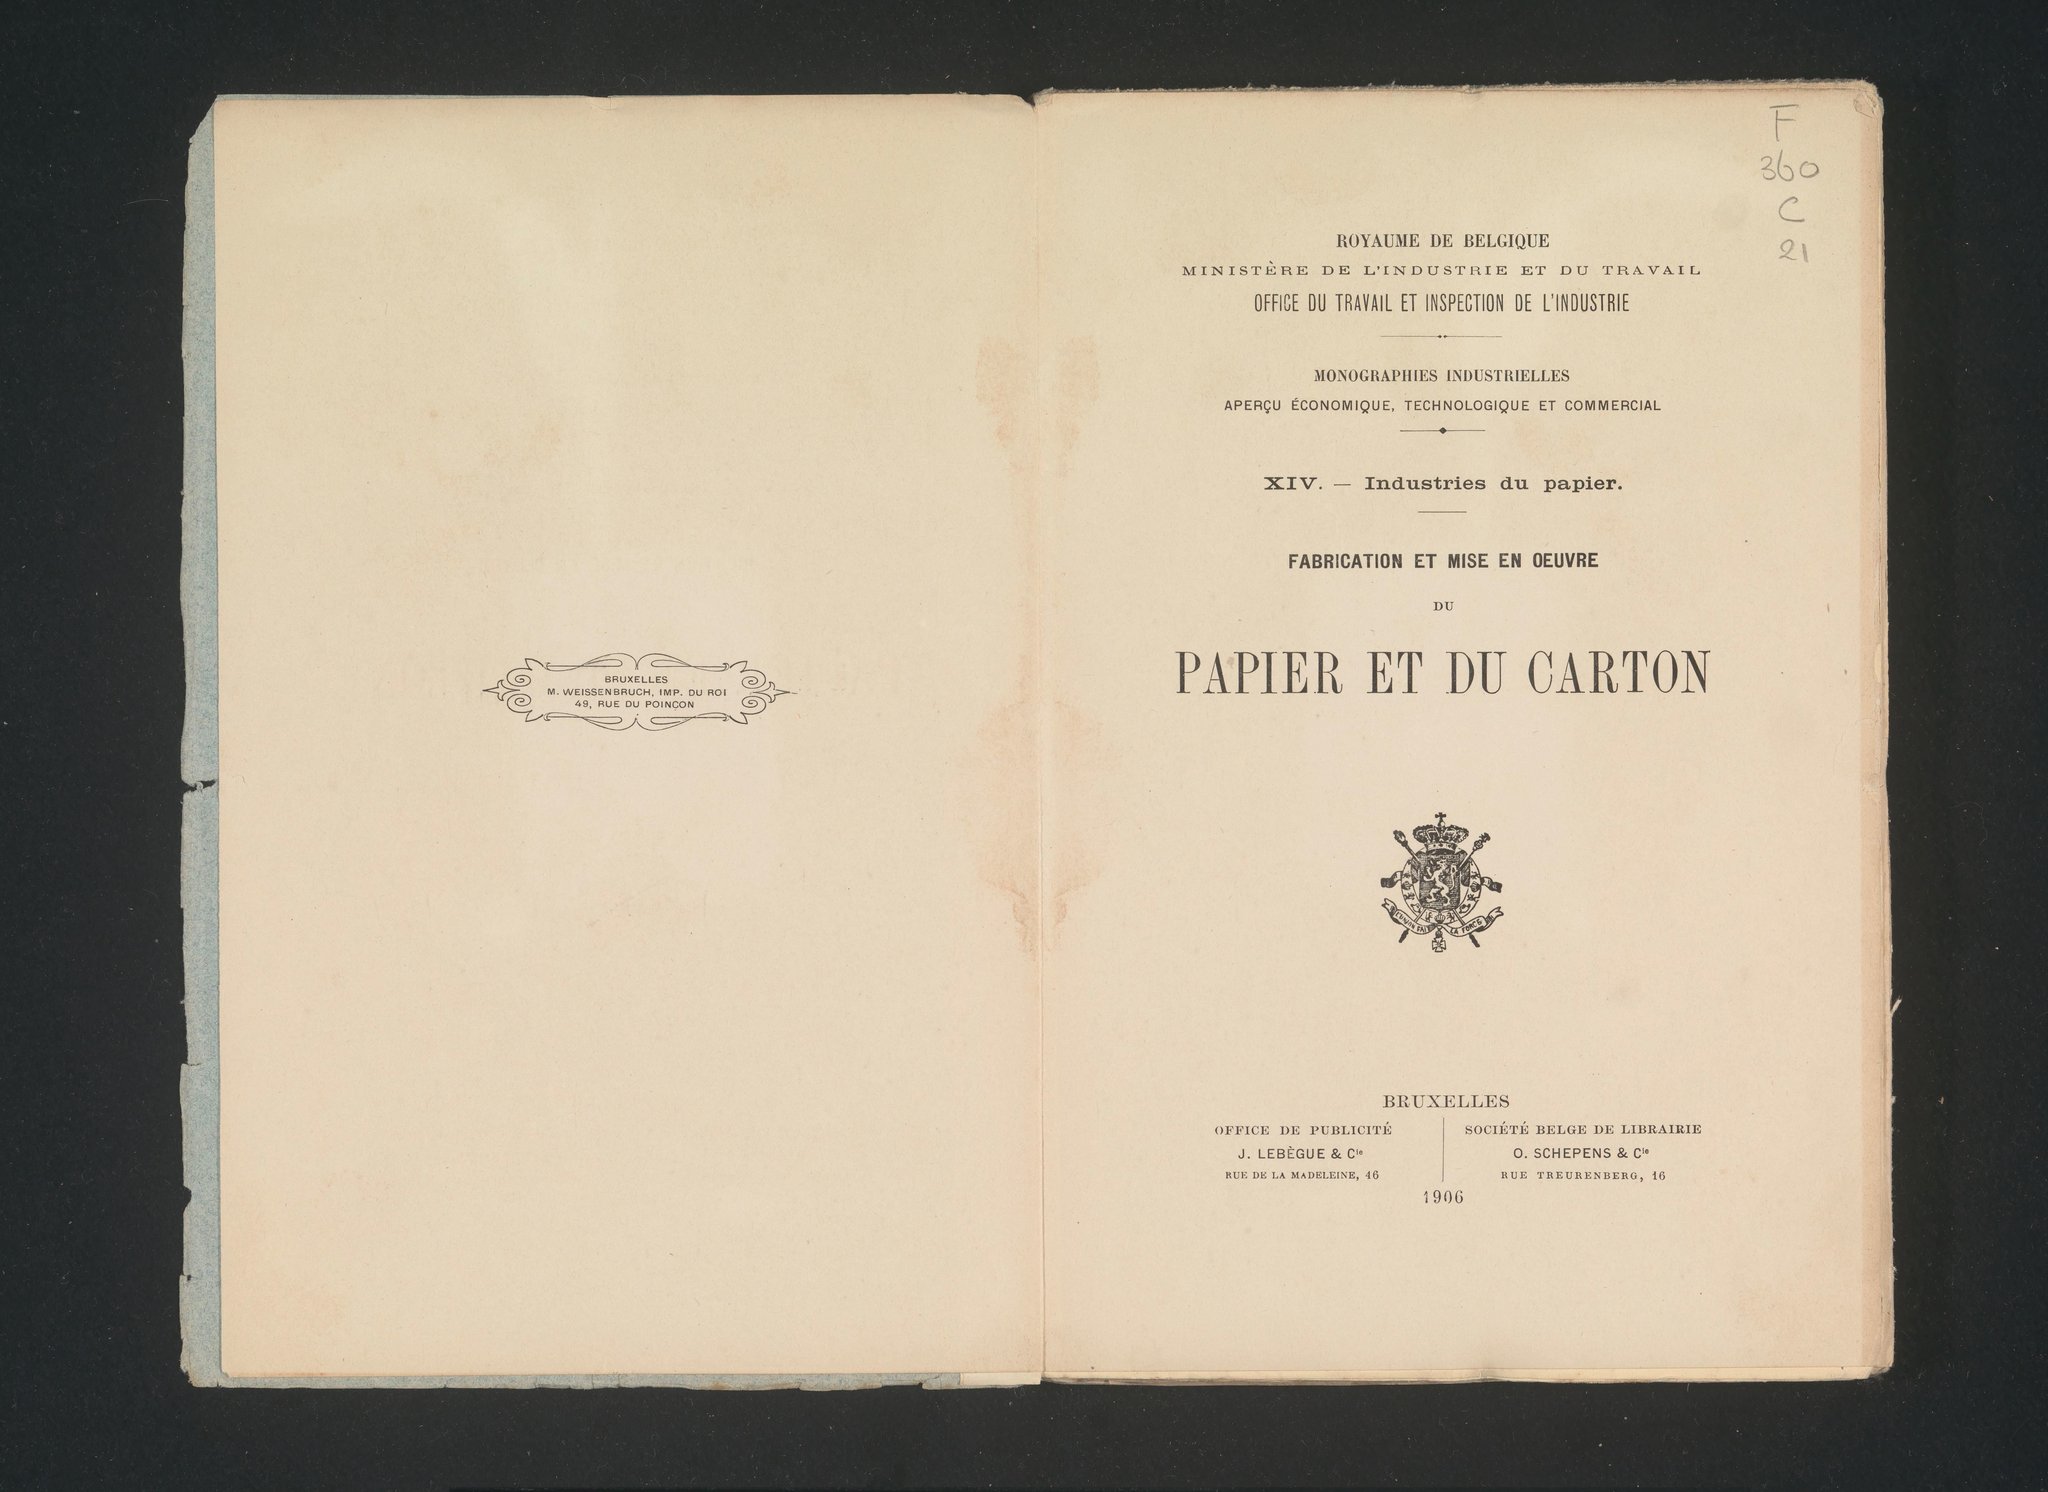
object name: book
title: Fabrication et mise en oeuvre du papier de du carton / Royaume de Belgique, Ministère de l'industrie et du travail, Office du travail et inspection de l'industrie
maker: m. weissenbruch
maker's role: printer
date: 1906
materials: paper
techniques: printing, engraving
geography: brussels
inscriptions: annotation: ‘JULY 1992’, number: ‘400’, bookplate: ‘SEDES SAPIENTIAE/ 1914 1940/ NON EVERTETUR/ DD. Ministère du Travail/ Bruxelles.’